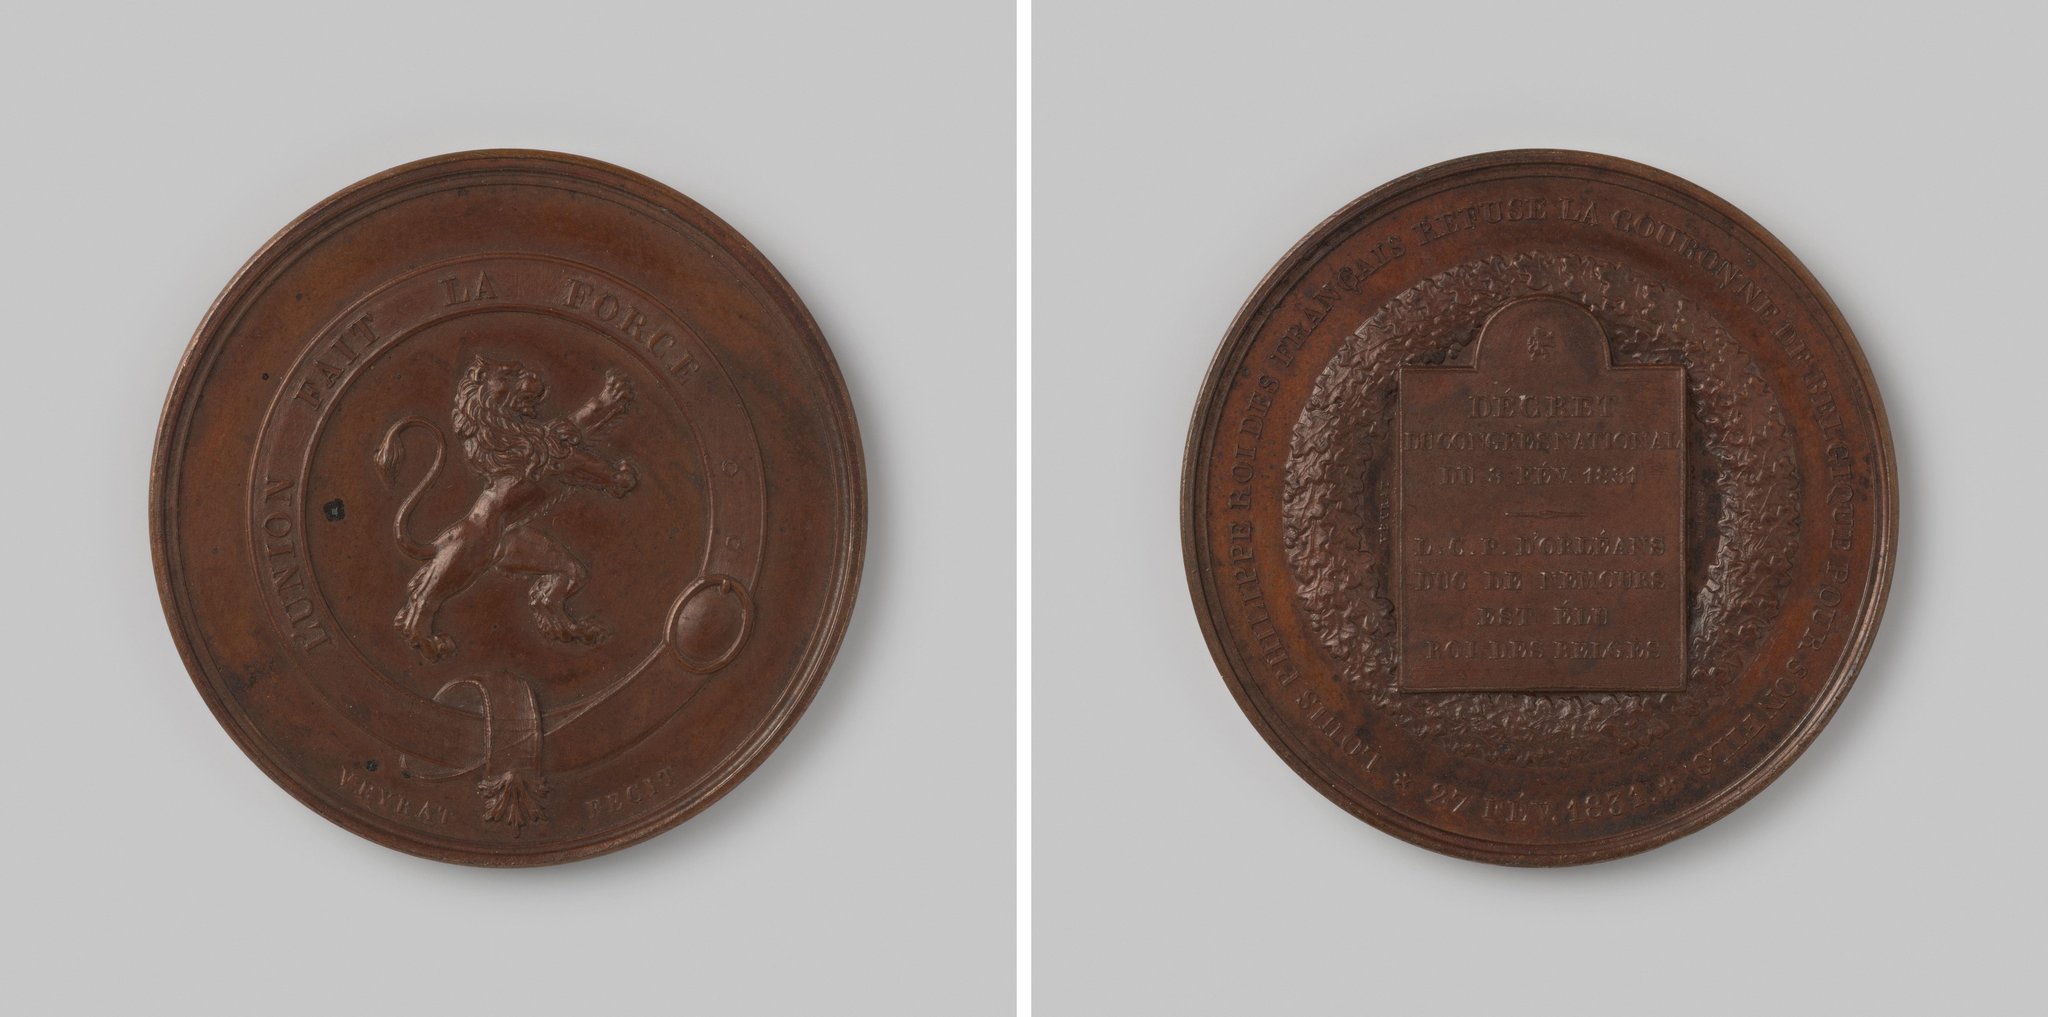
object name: history medal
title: Weigering van de Belgische kroon door de Hertog van Nemours 1831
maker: adrien hippolyte veyrat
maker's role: medailleur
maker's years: 1803-1883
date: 1831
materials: bronze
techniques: striking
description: Bronzen penning, op de voorzijde een klimmende leeuw naar rechts binnen een gordel met tekst, op de keerzijde een tablet met zeven regels tekst op een dichte eikenkrans, met omschrift.